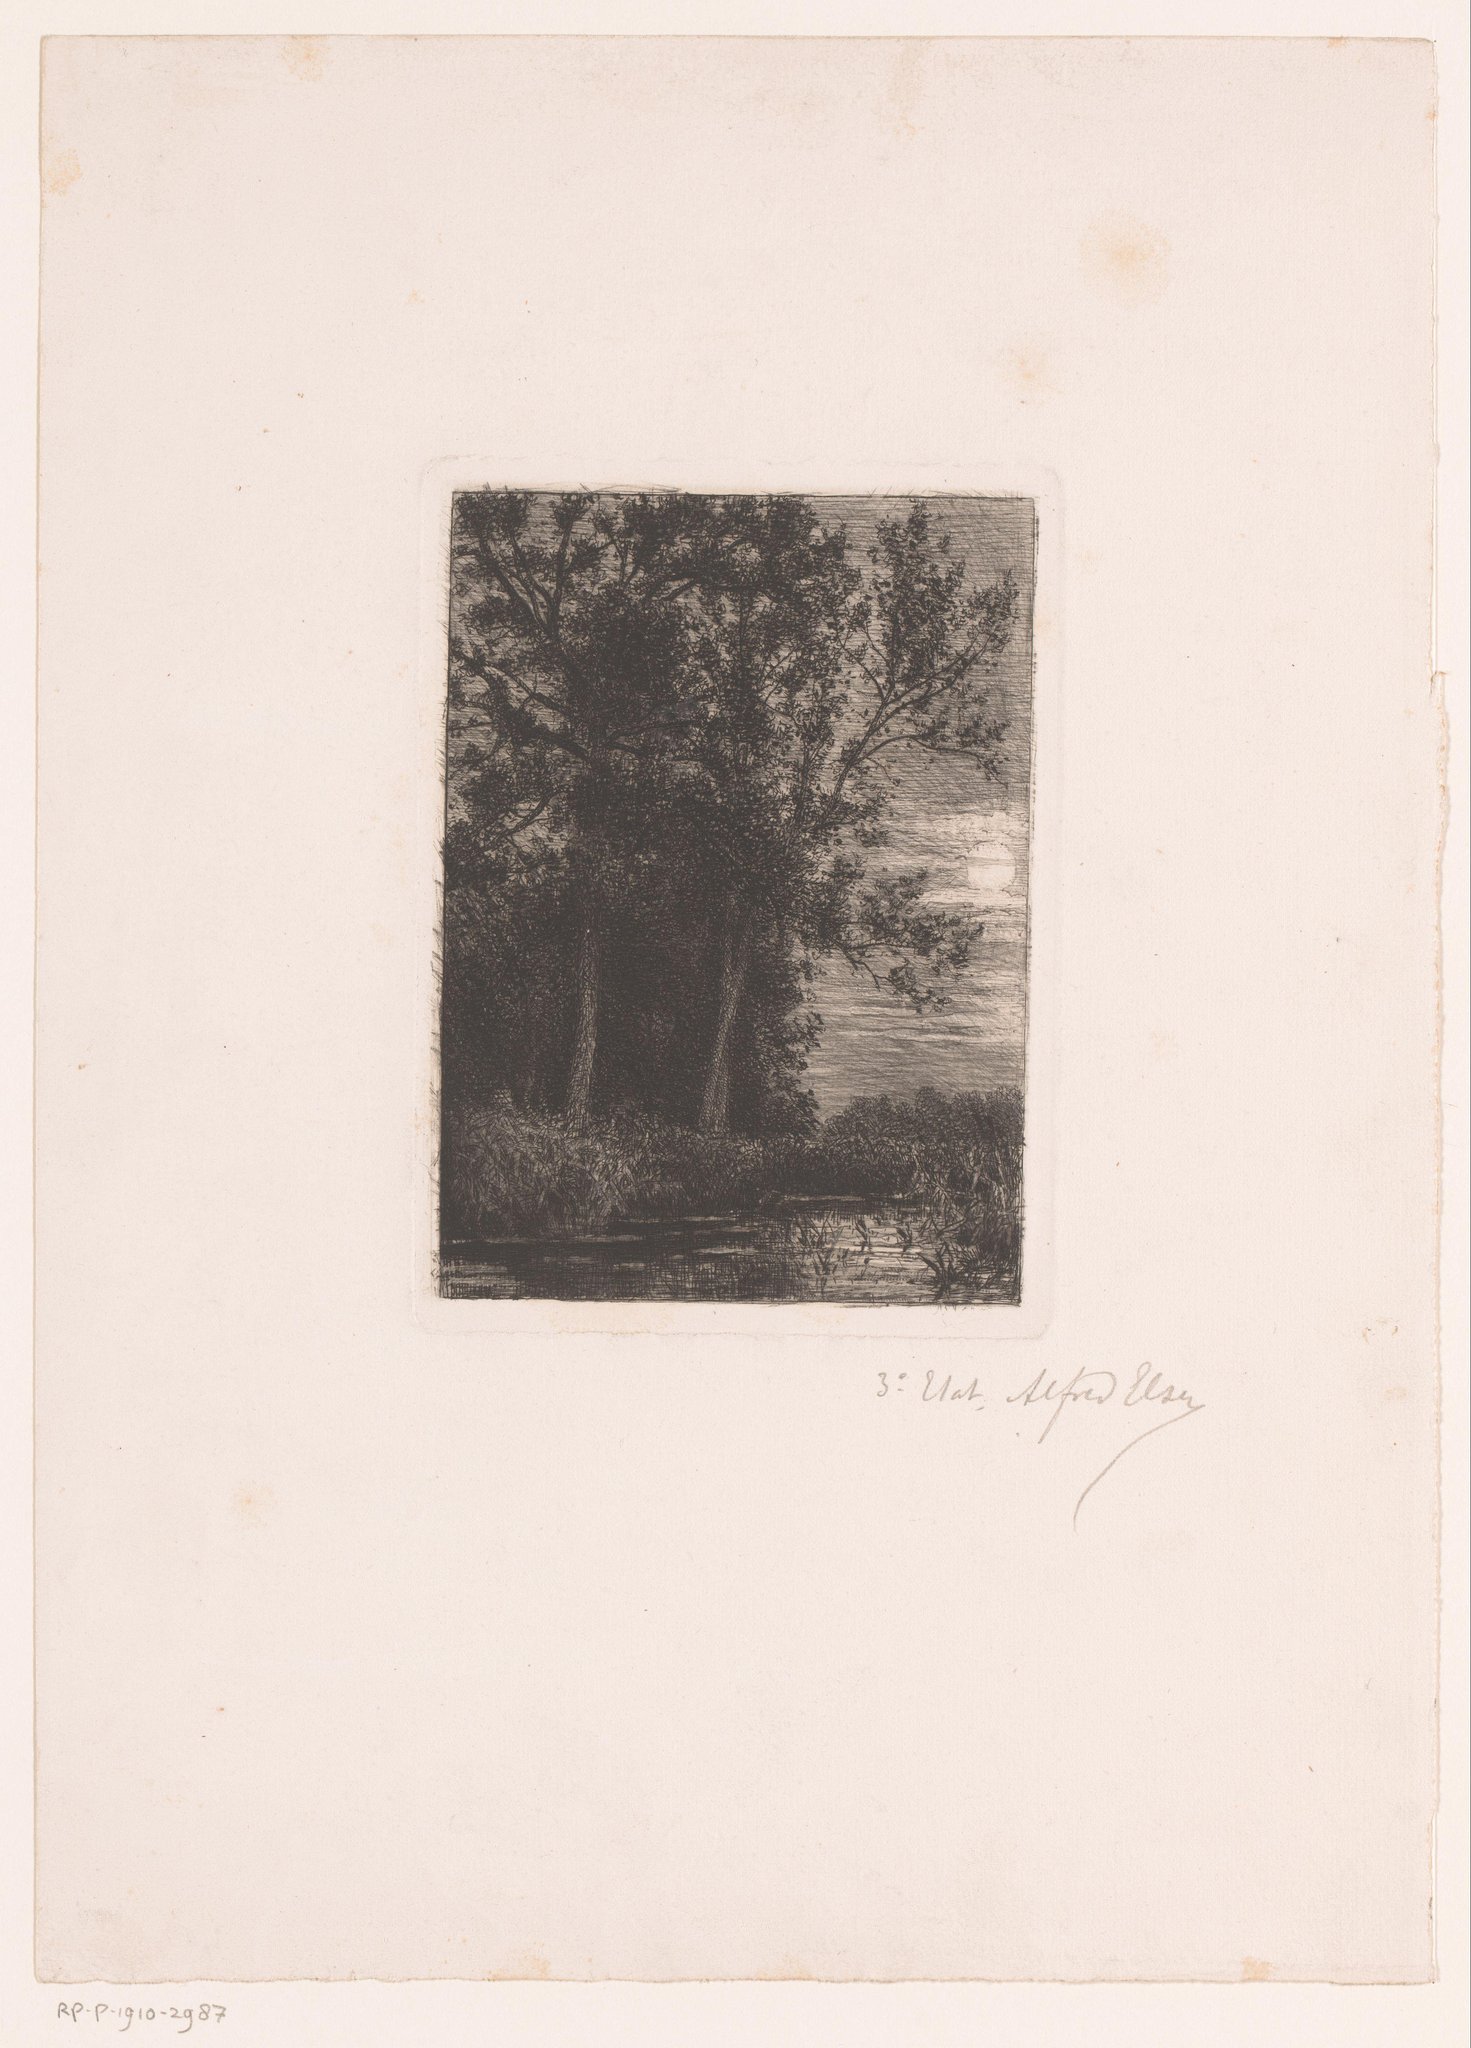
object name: print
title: Landschap met bomen aan het water in maanlicht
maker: alfred elsen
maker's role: painter, print maker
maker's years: 1850-1914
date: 1860-1910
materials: paper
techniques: etching, intaglio, roulette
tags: full moon, lake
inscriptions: collector's mark: Lugt 2228, inscription: ‘3e Etat’